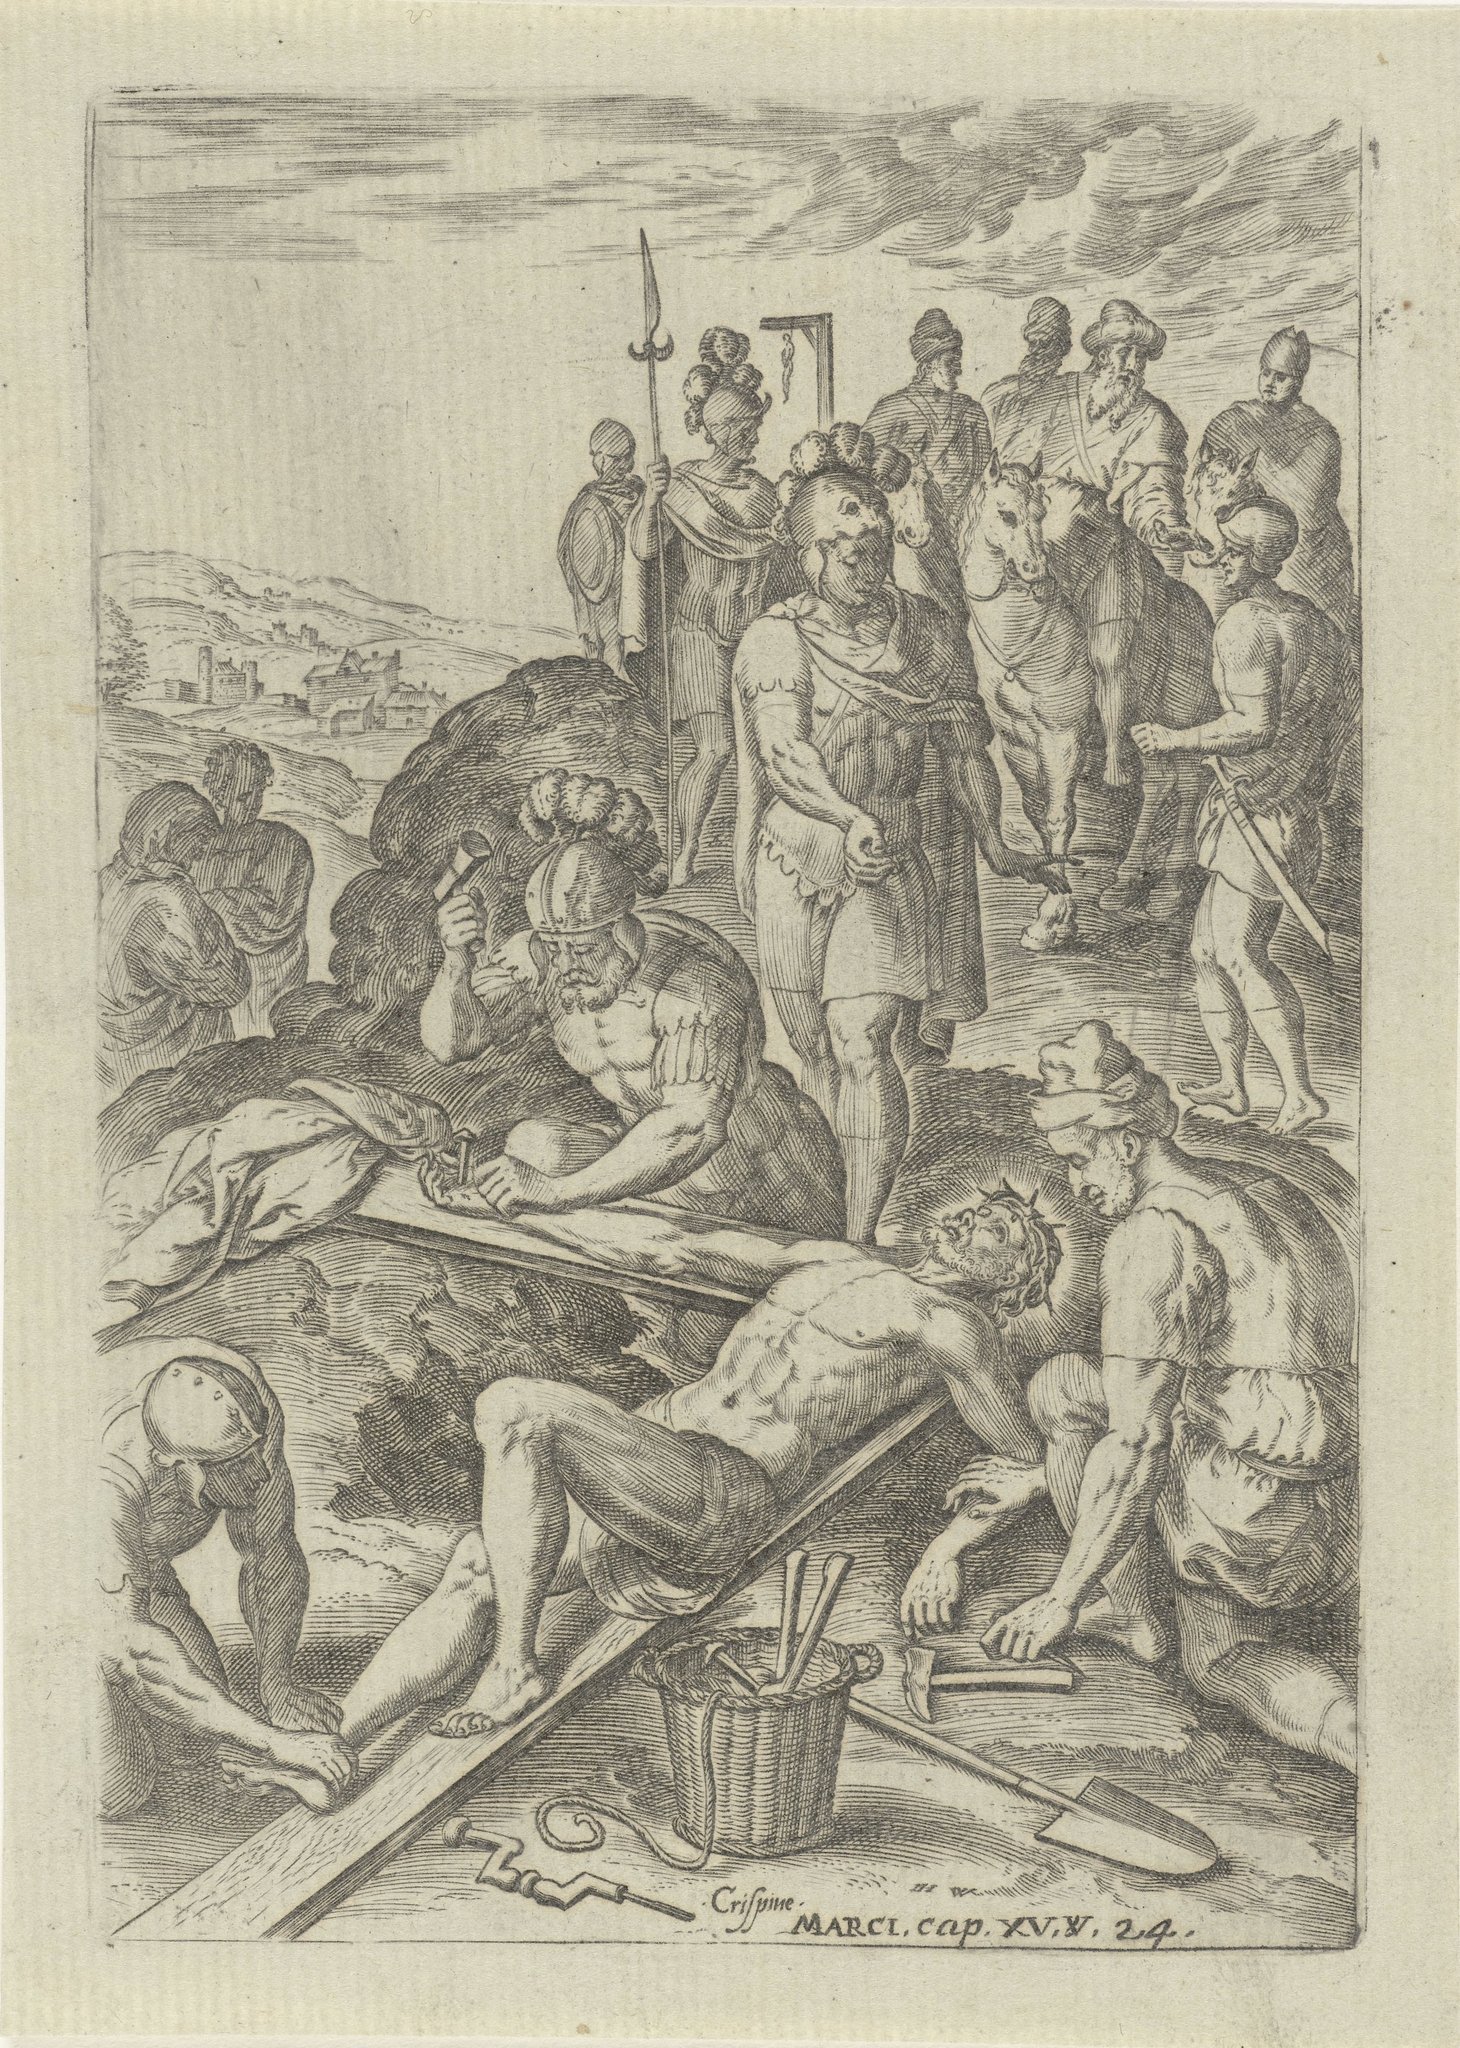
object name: print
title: Scènes uit de Bijbel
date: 1583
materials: paper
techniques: engraving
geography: antwerp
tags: making of the cross ~ prelude to christ's death on the cross, the erection of the cross: christ is nailed to the cross which lies on the ground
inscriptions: collector's mark: Lugt 2228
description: Boekillustratie bij het verhaal van de kruisiging van Christus (Marcus 15:24). Romeinse soldaten kruisigen Christus en nemen zijn mantel af. De prent bevat een onderschrift met een verwijzing naar de bijhorende Bijbelpassage.